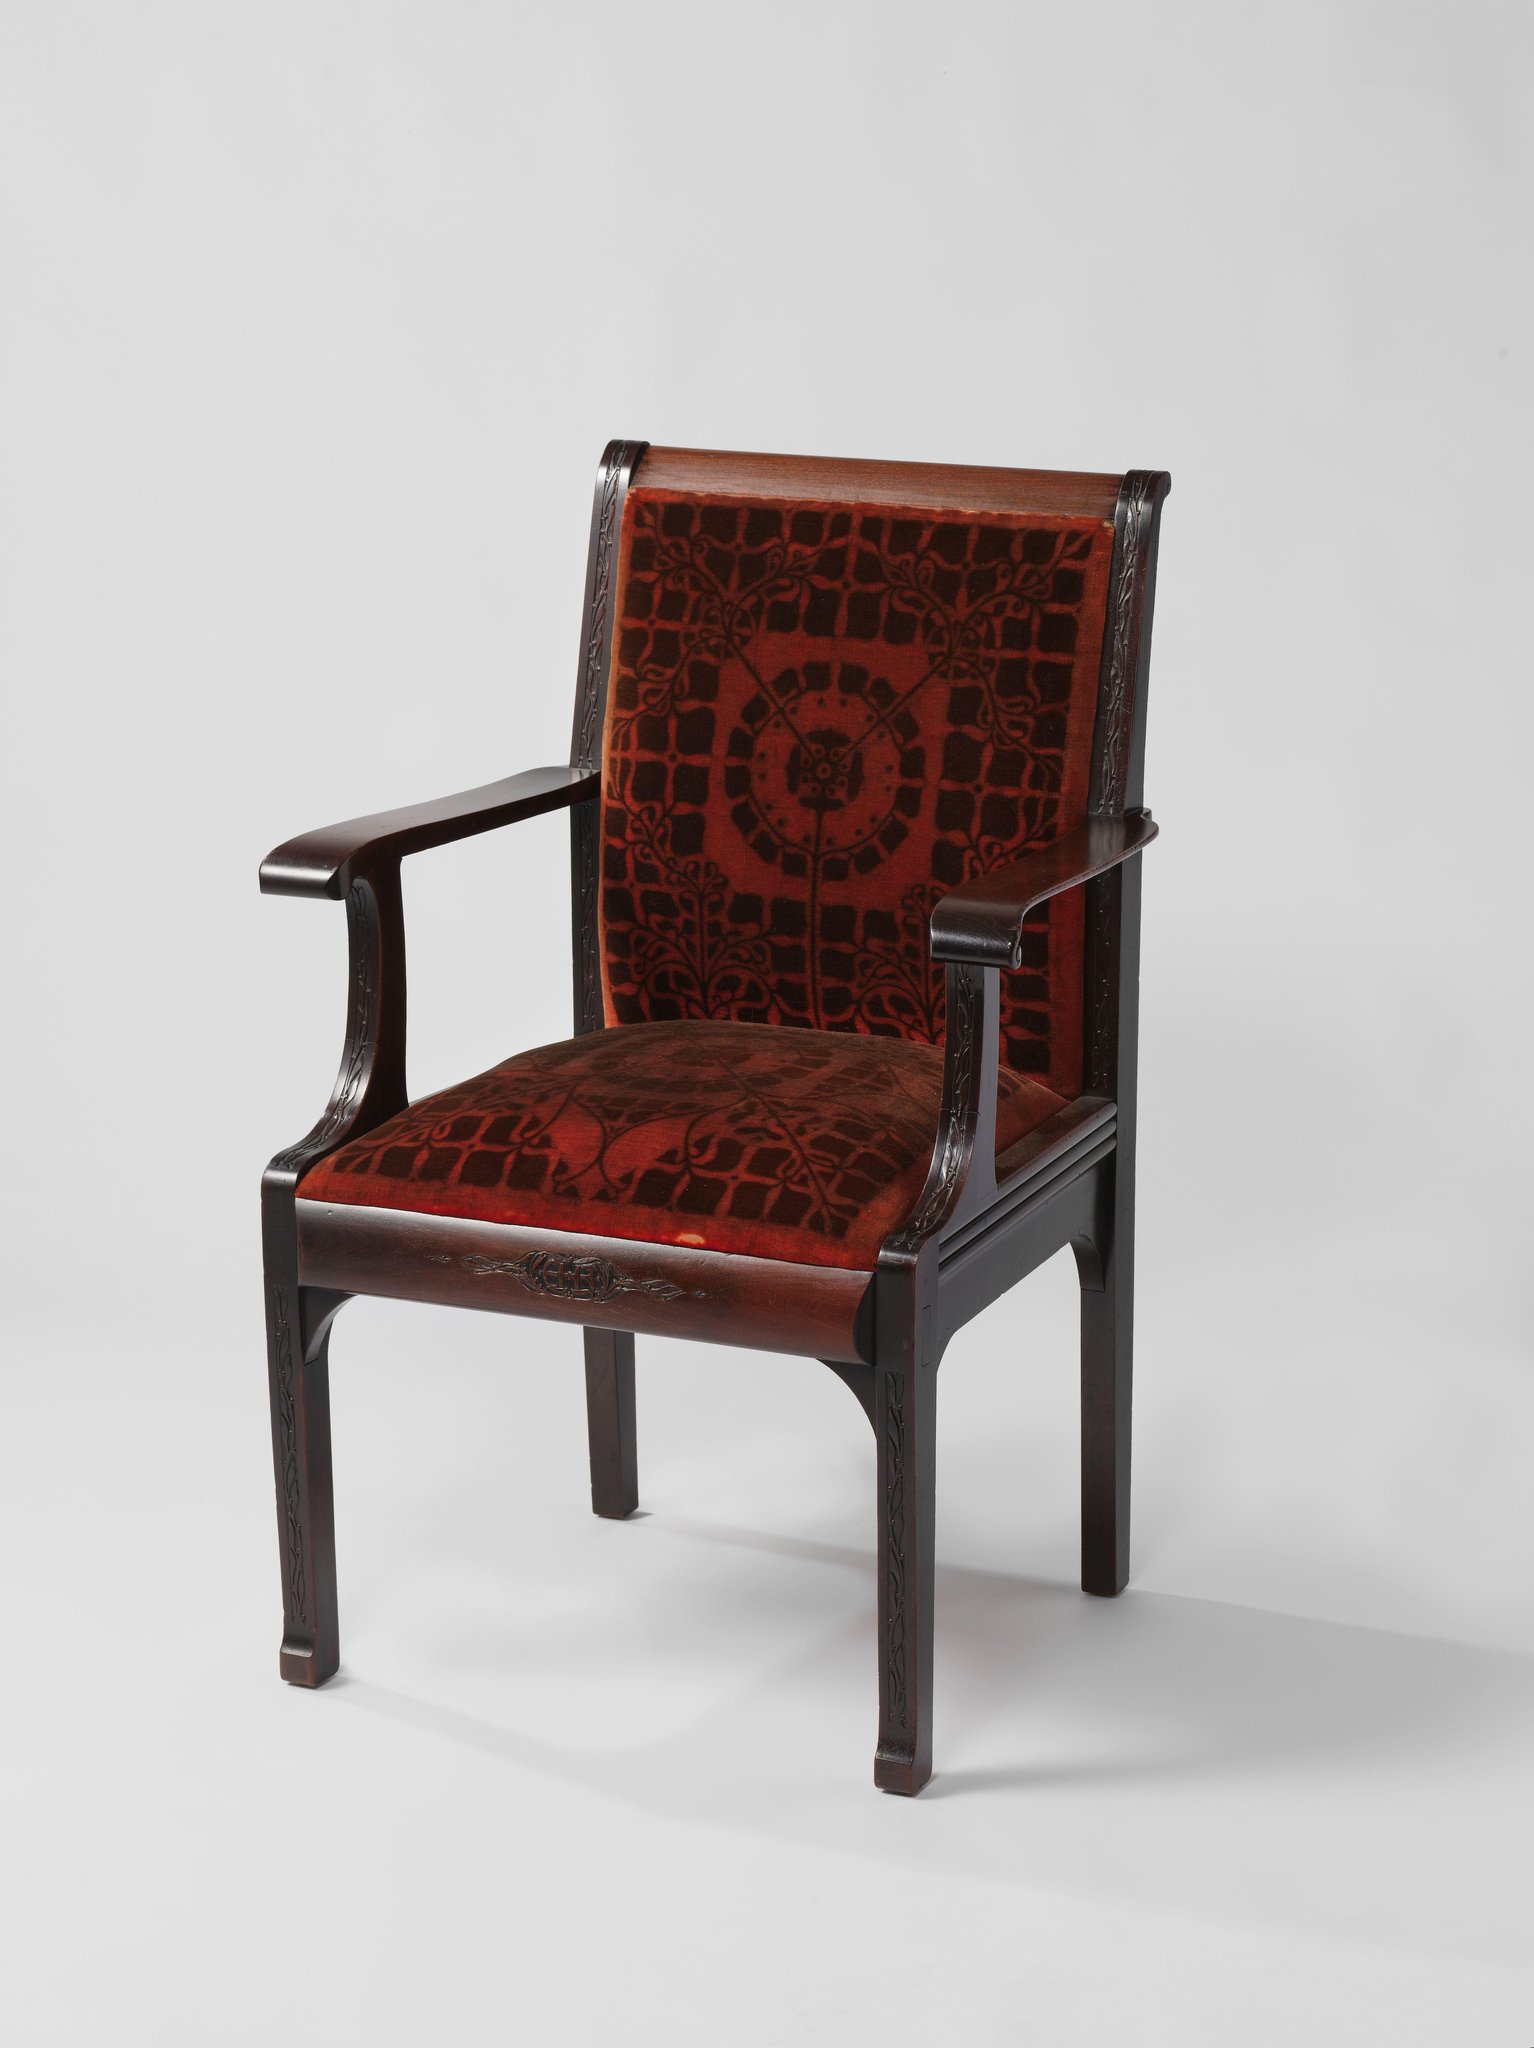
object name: armchair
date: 1908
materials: wood, textile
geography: amsterdam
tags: ornaments ~ art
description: This chair was part of the interior design of a private house on the Museumplein in Amsterdam. The occupant and commissioner was the tobacco wholesaler E.R. Harkema; his monogram EHR is carved in the wood of the seat’s front apron. Jan Mensing hand-printed the seat and back cover with a geometrical pattern of foliage and vine motifs.